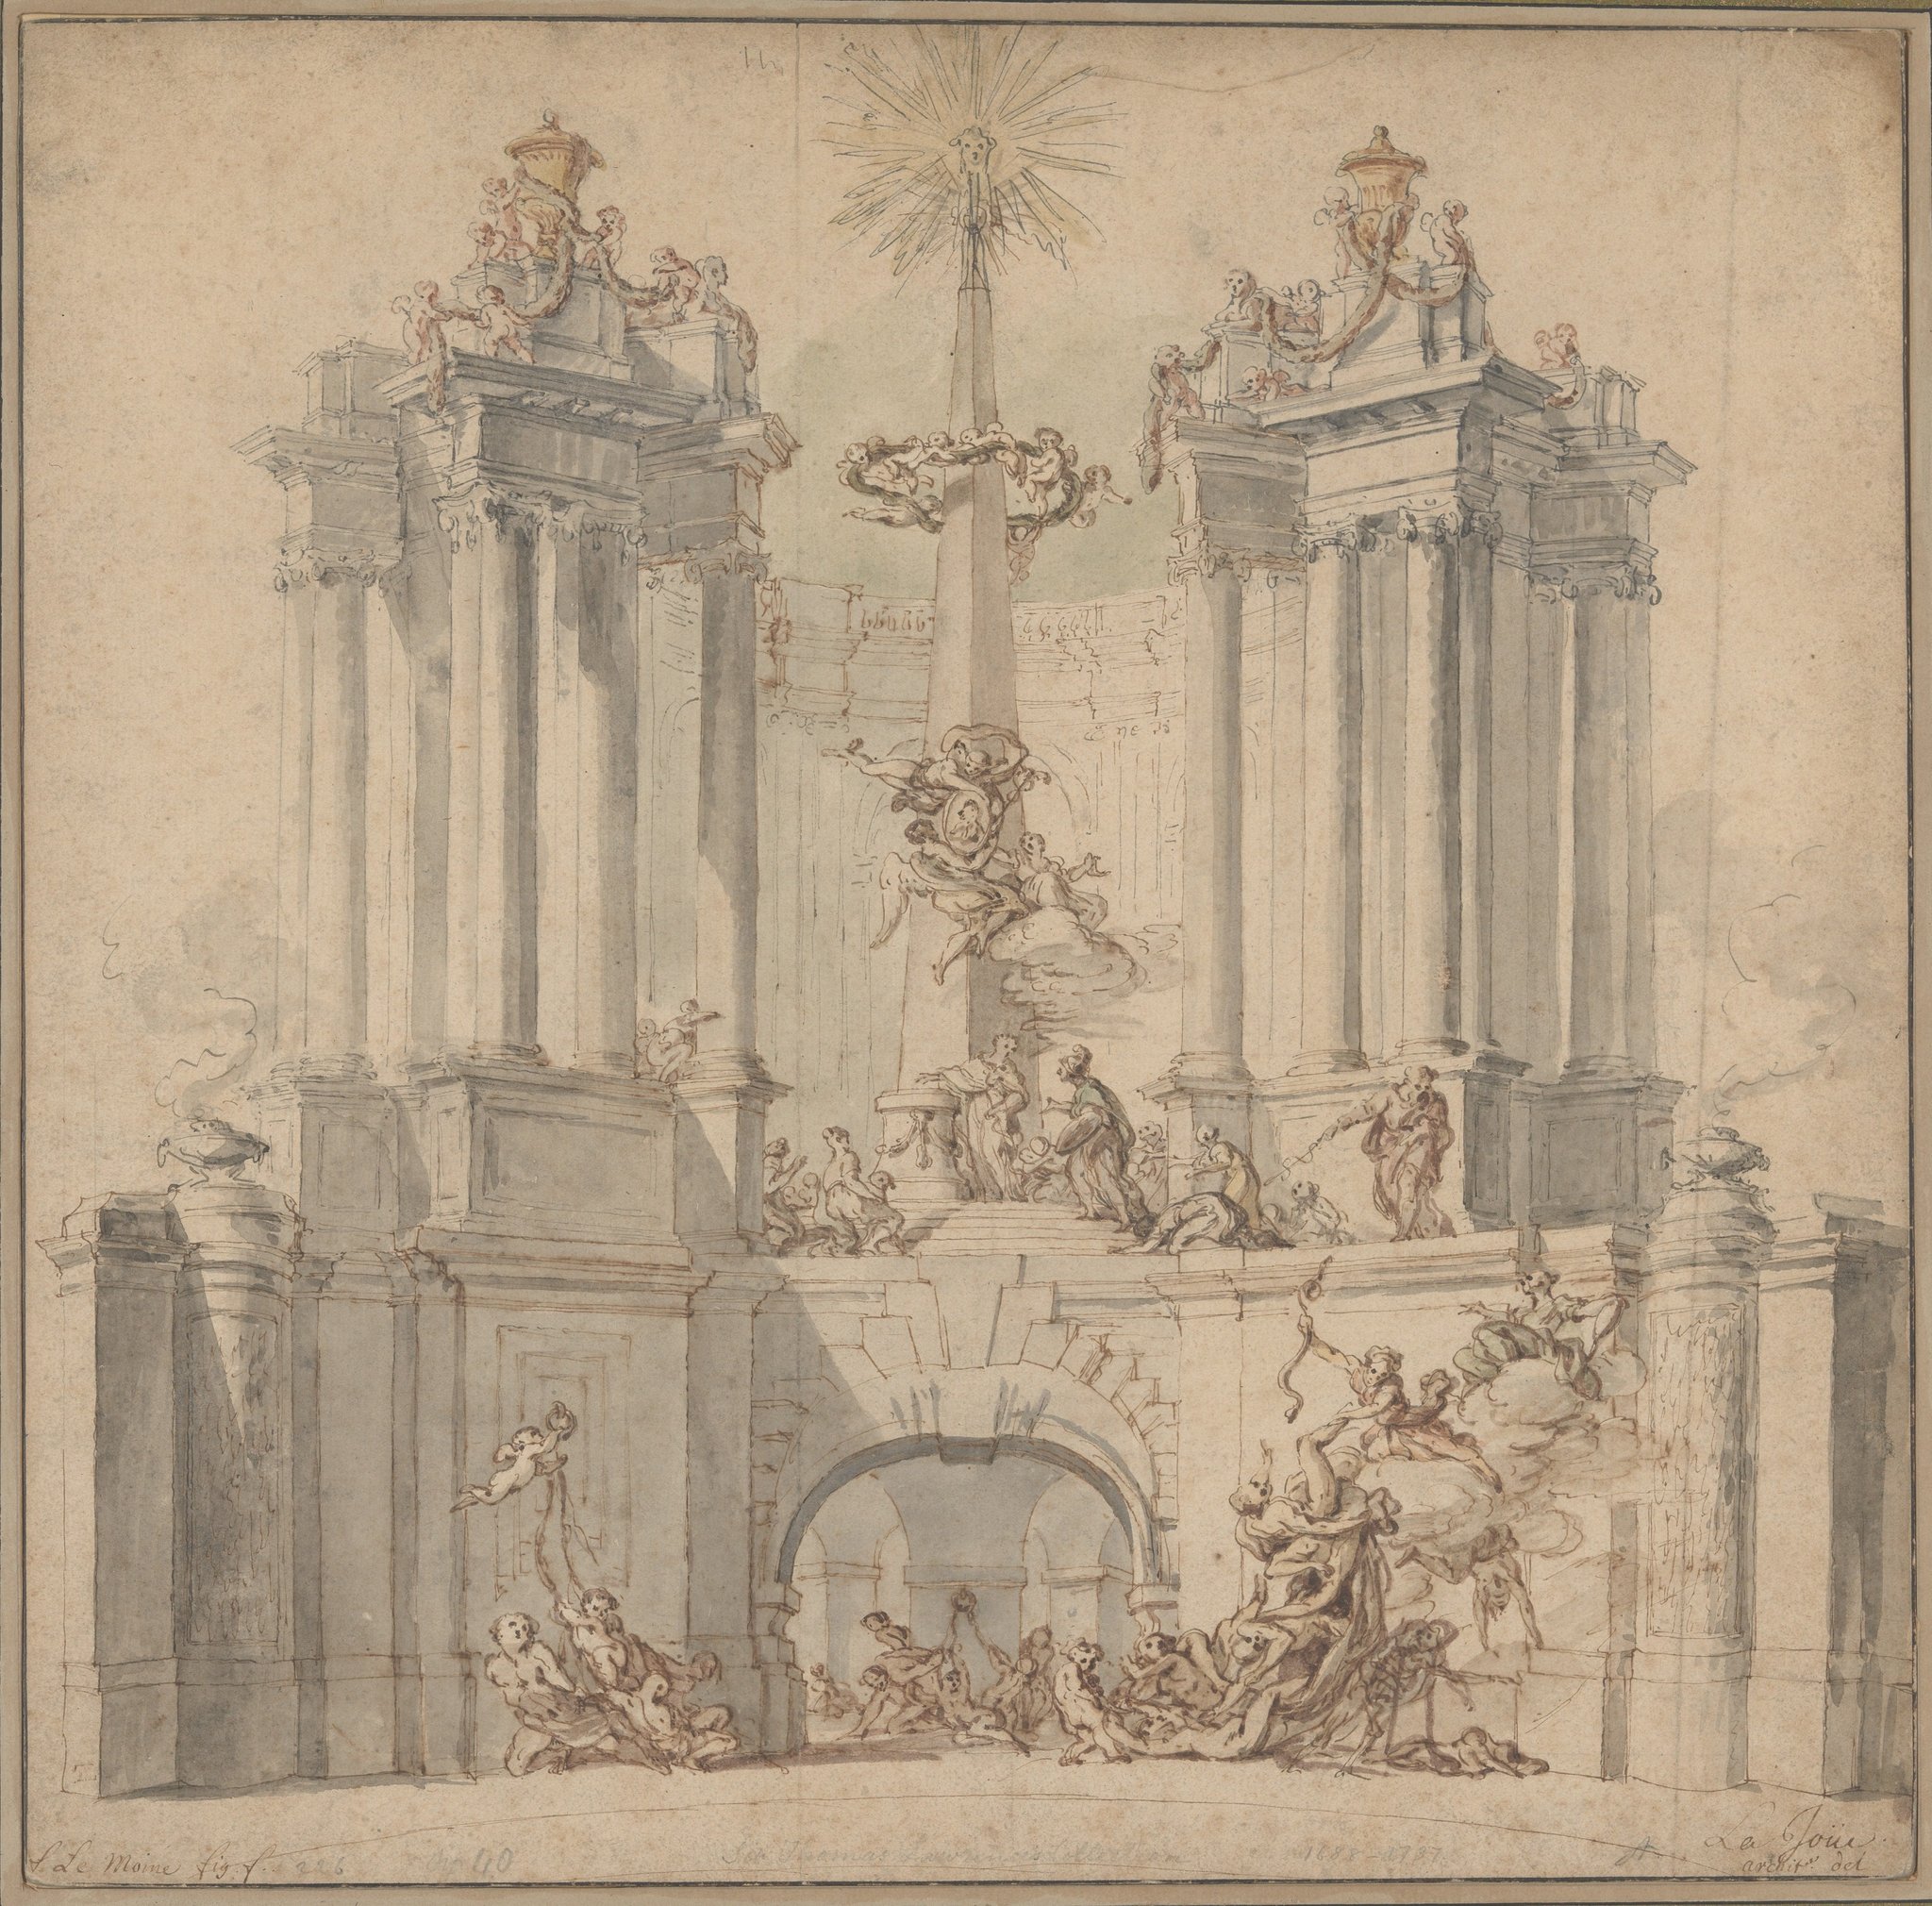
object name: drawing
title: Fireworks Display for the Convalescence of Louis XV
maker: jacques de lajoüe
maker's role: artist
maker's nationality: french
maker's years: 1686-1761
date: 1726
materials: chalk, ink, watercolor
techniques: brush, pen, wash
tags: columns,obelisks,fireworks